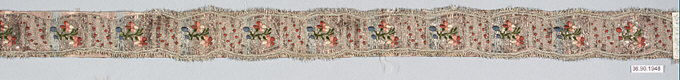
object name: galloon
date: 1701-1800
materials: silk